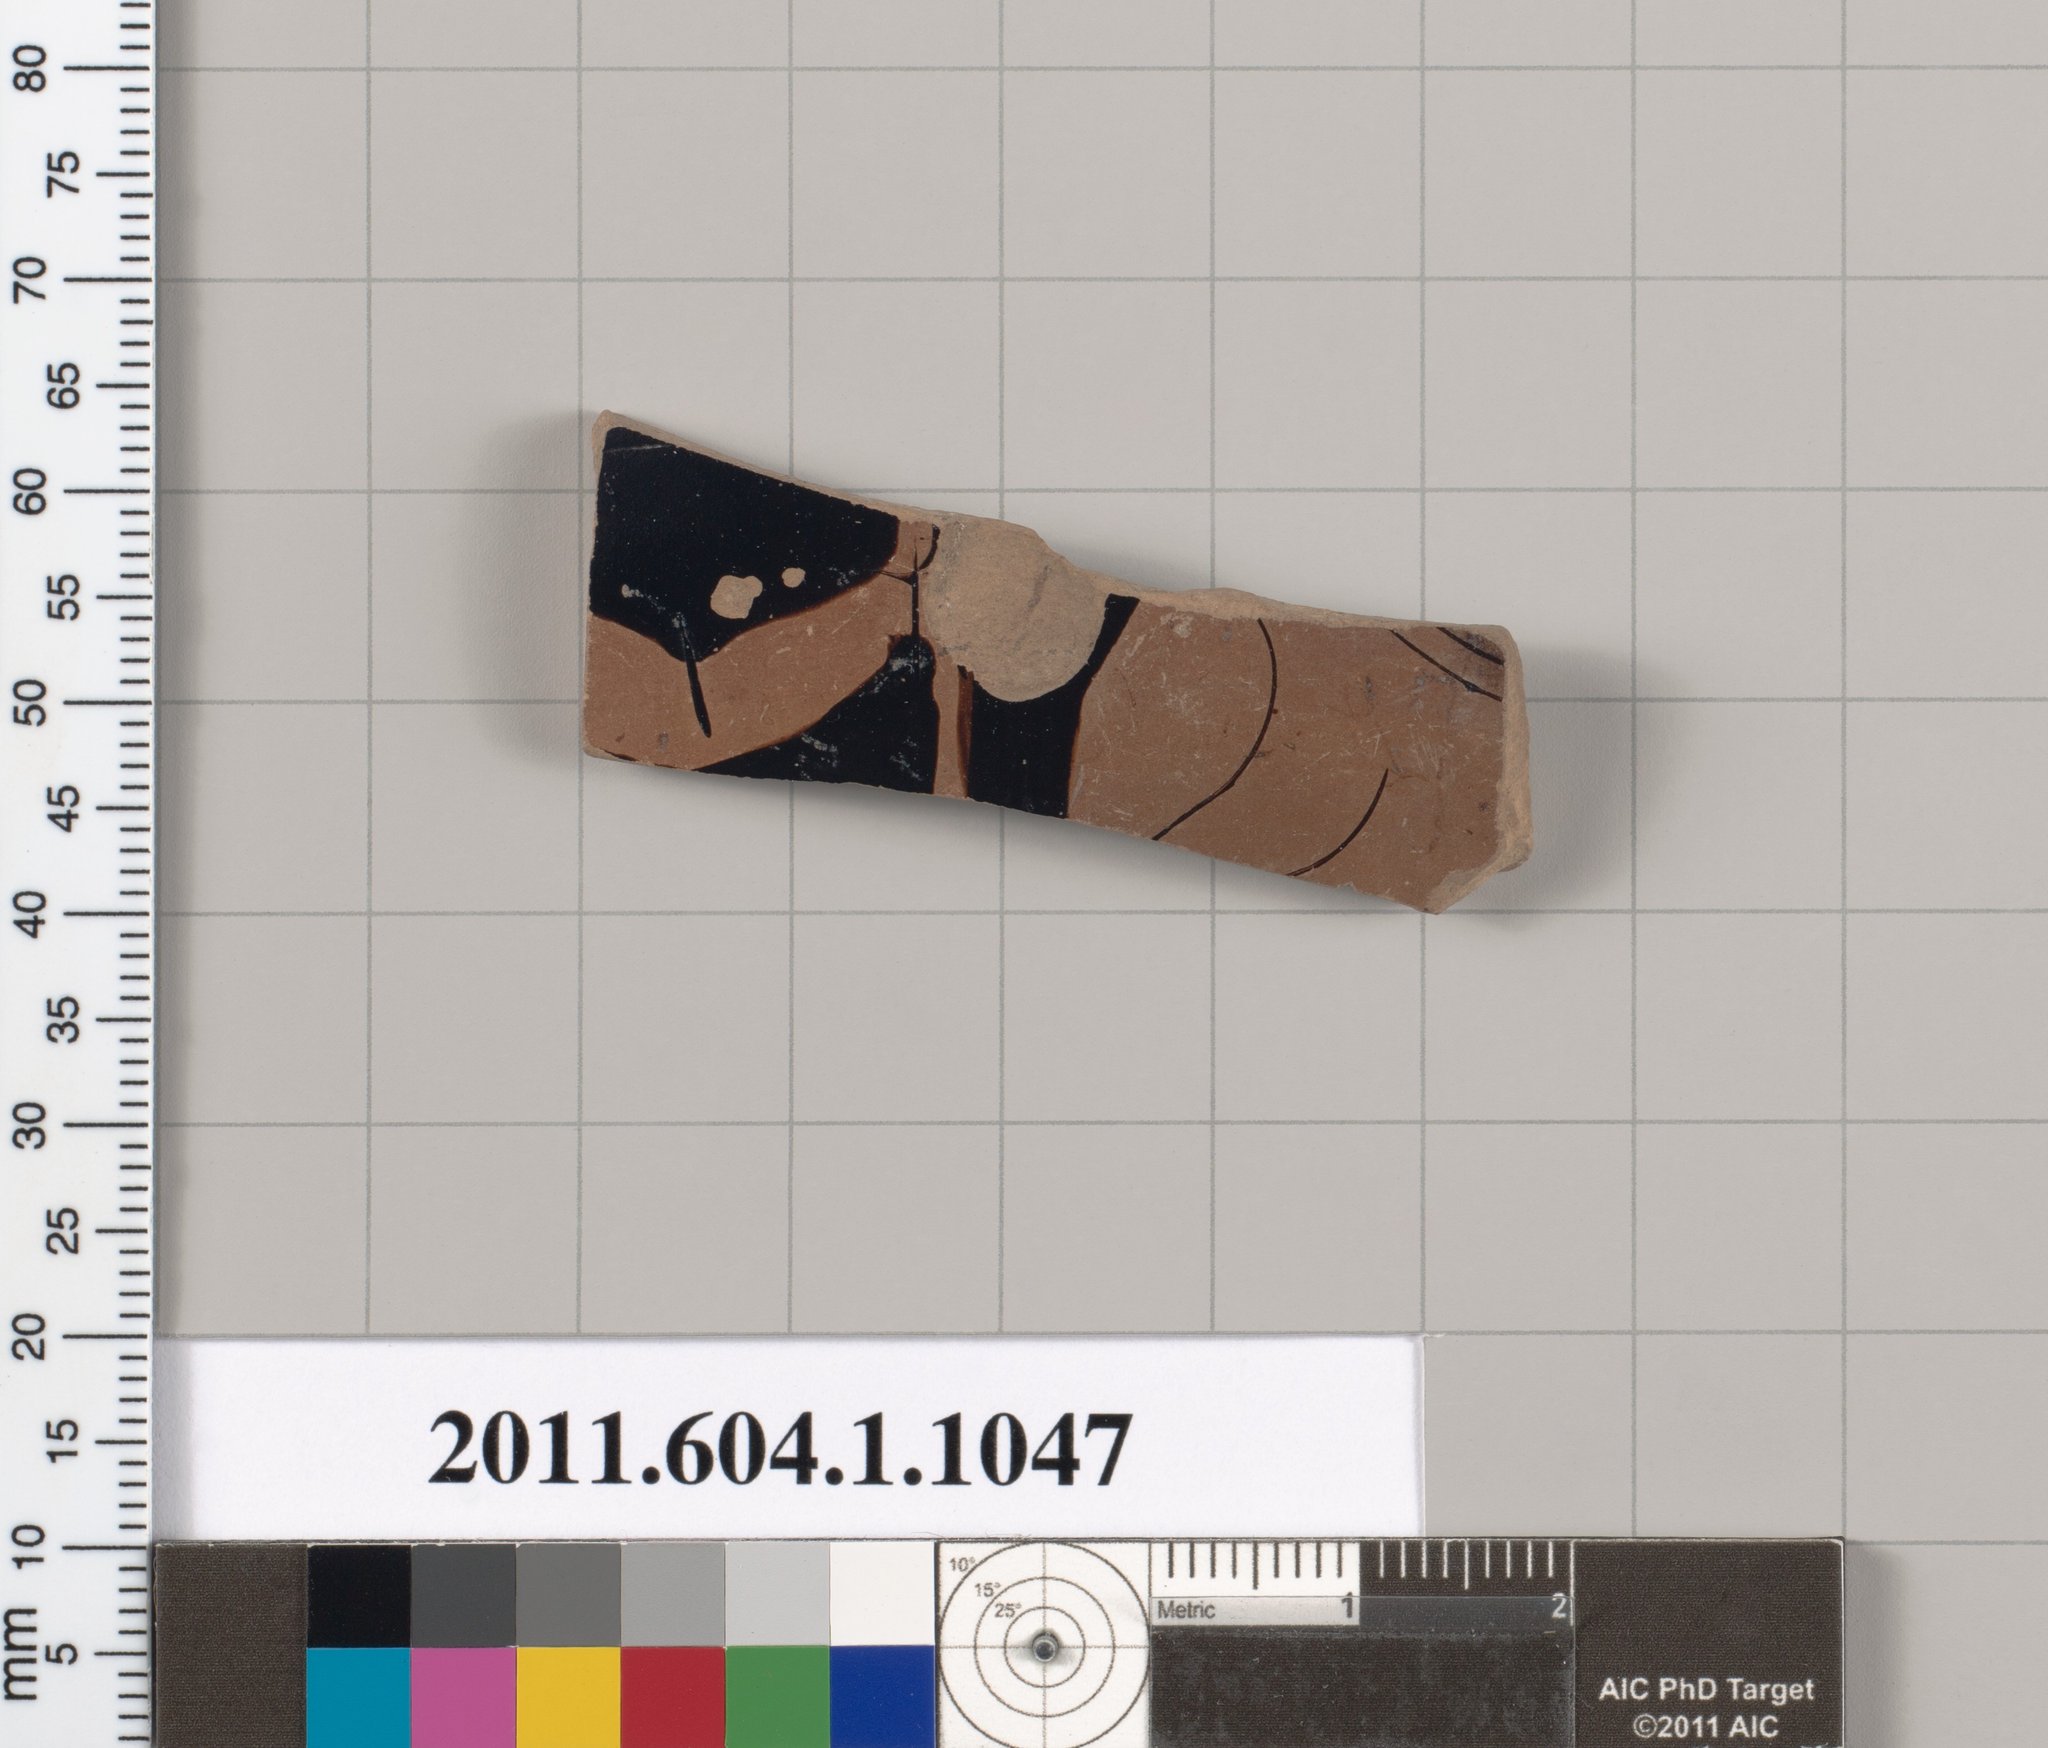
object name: kylix fragment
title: Terracotta fragment of a kylix (drinking cup)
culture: greek, attic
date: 475-451 BCE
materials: terracotta